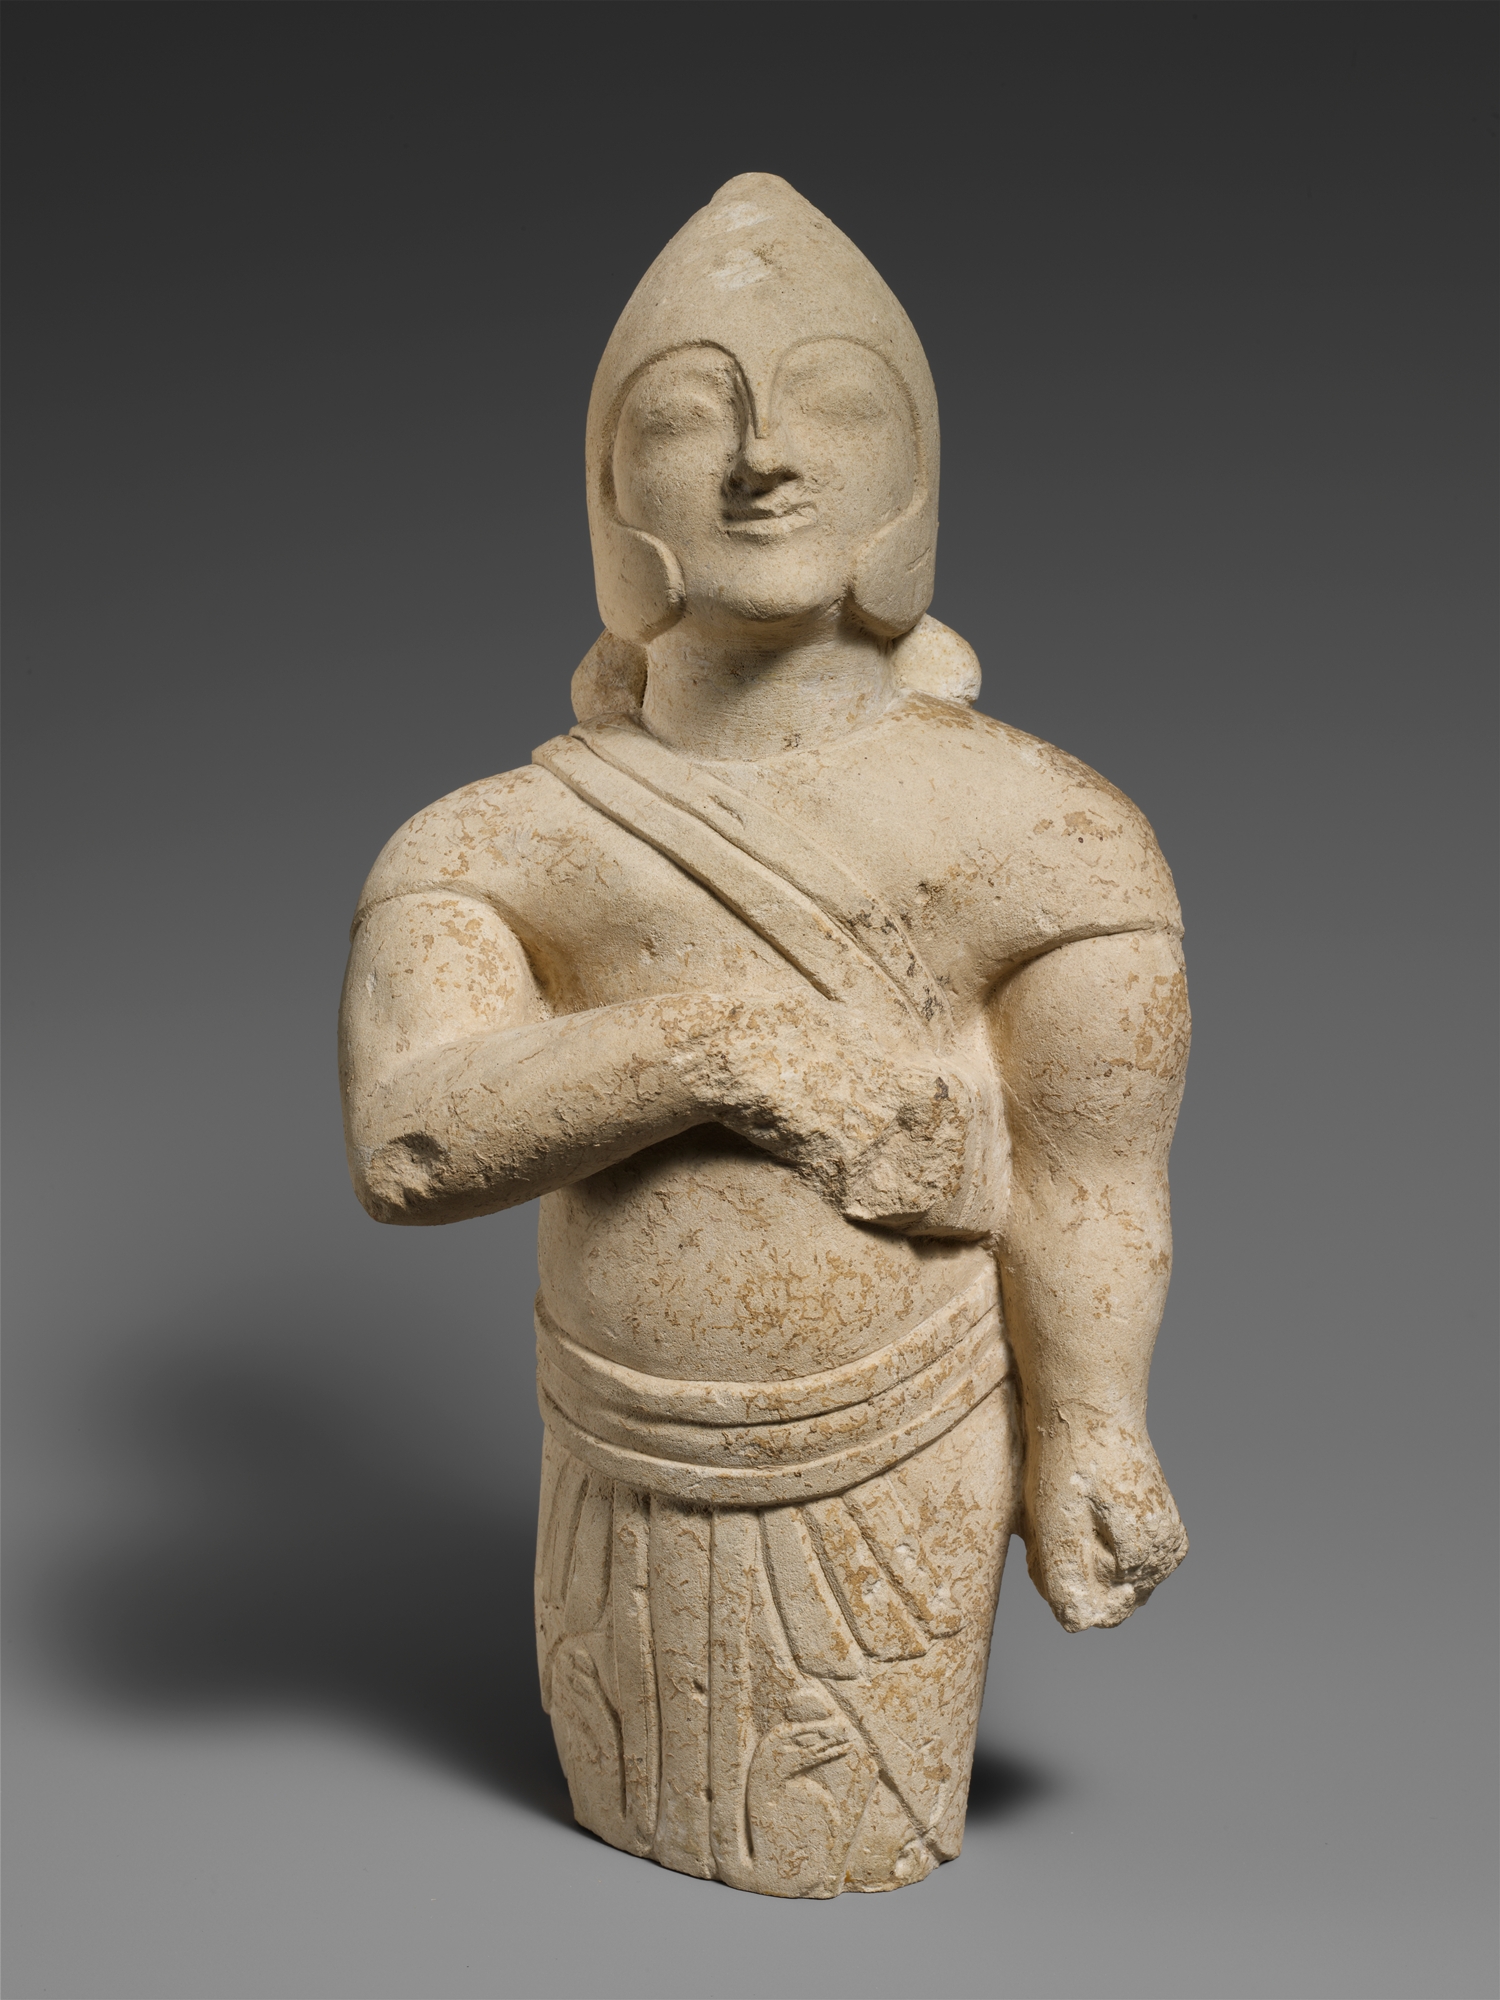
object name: statue of a warrior in egyptian dress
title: Limestone warrior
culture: cypriot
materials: limestone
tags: soldiers,helmets